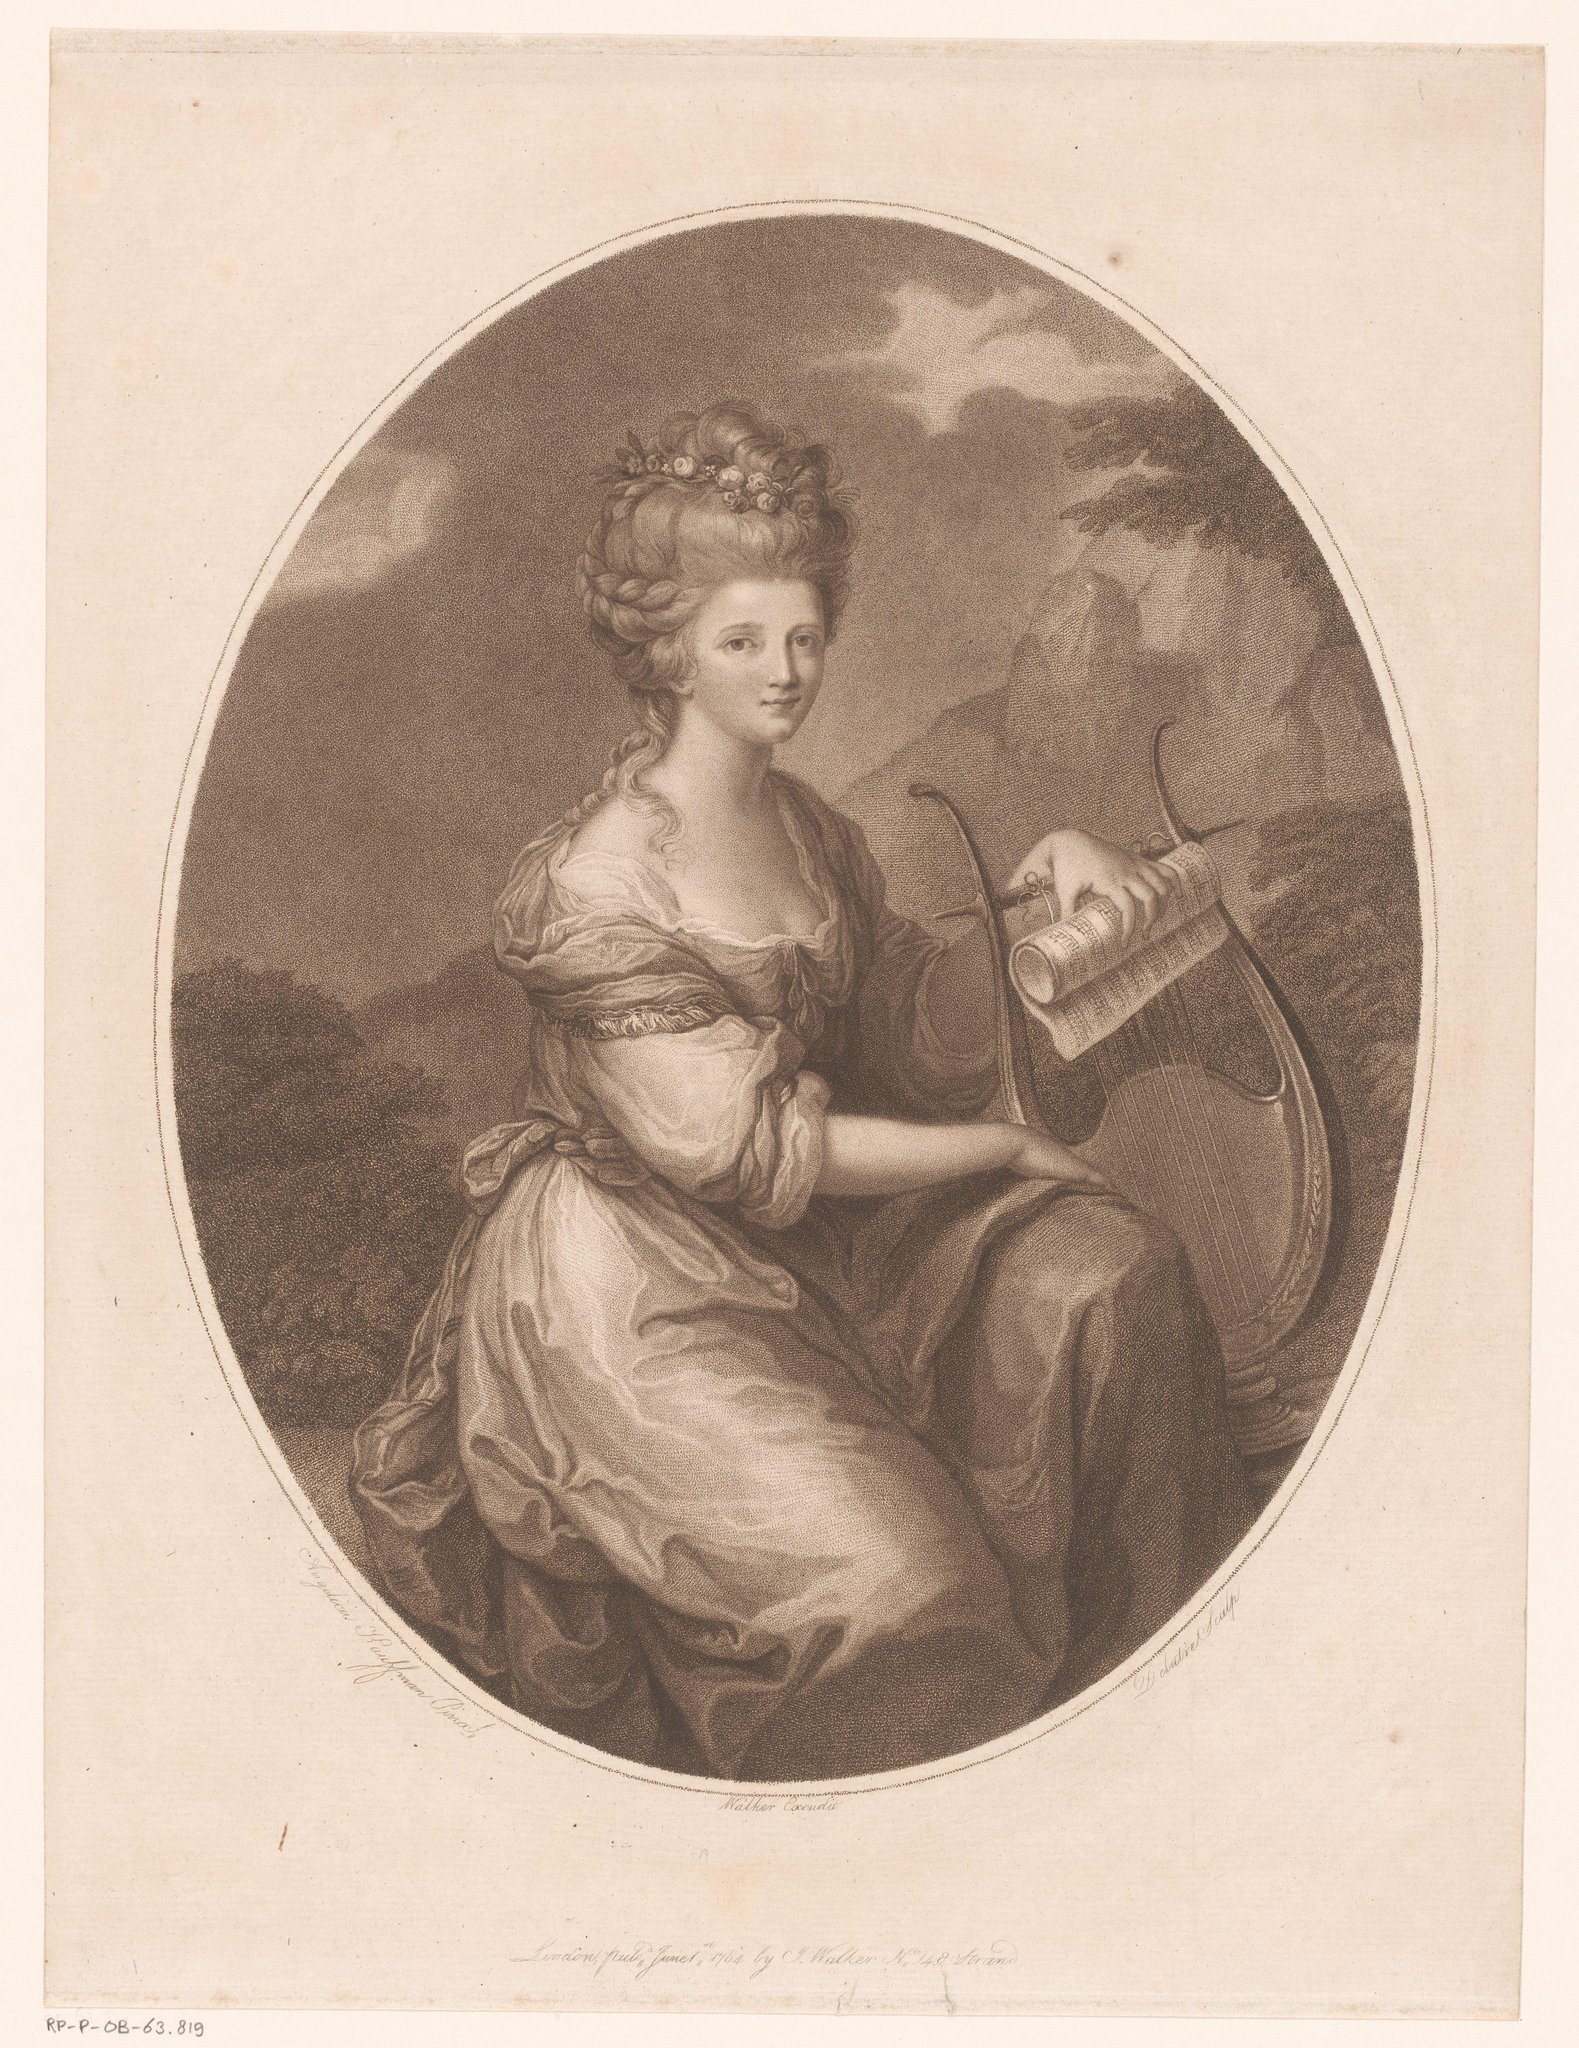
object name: print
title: Portret van Sarah Bates met harp en bladmuziek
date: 1784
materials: paper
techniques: etching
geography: london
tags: historical persons, harp - cc - out of doors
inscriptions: collector's mark: Lugt 2228